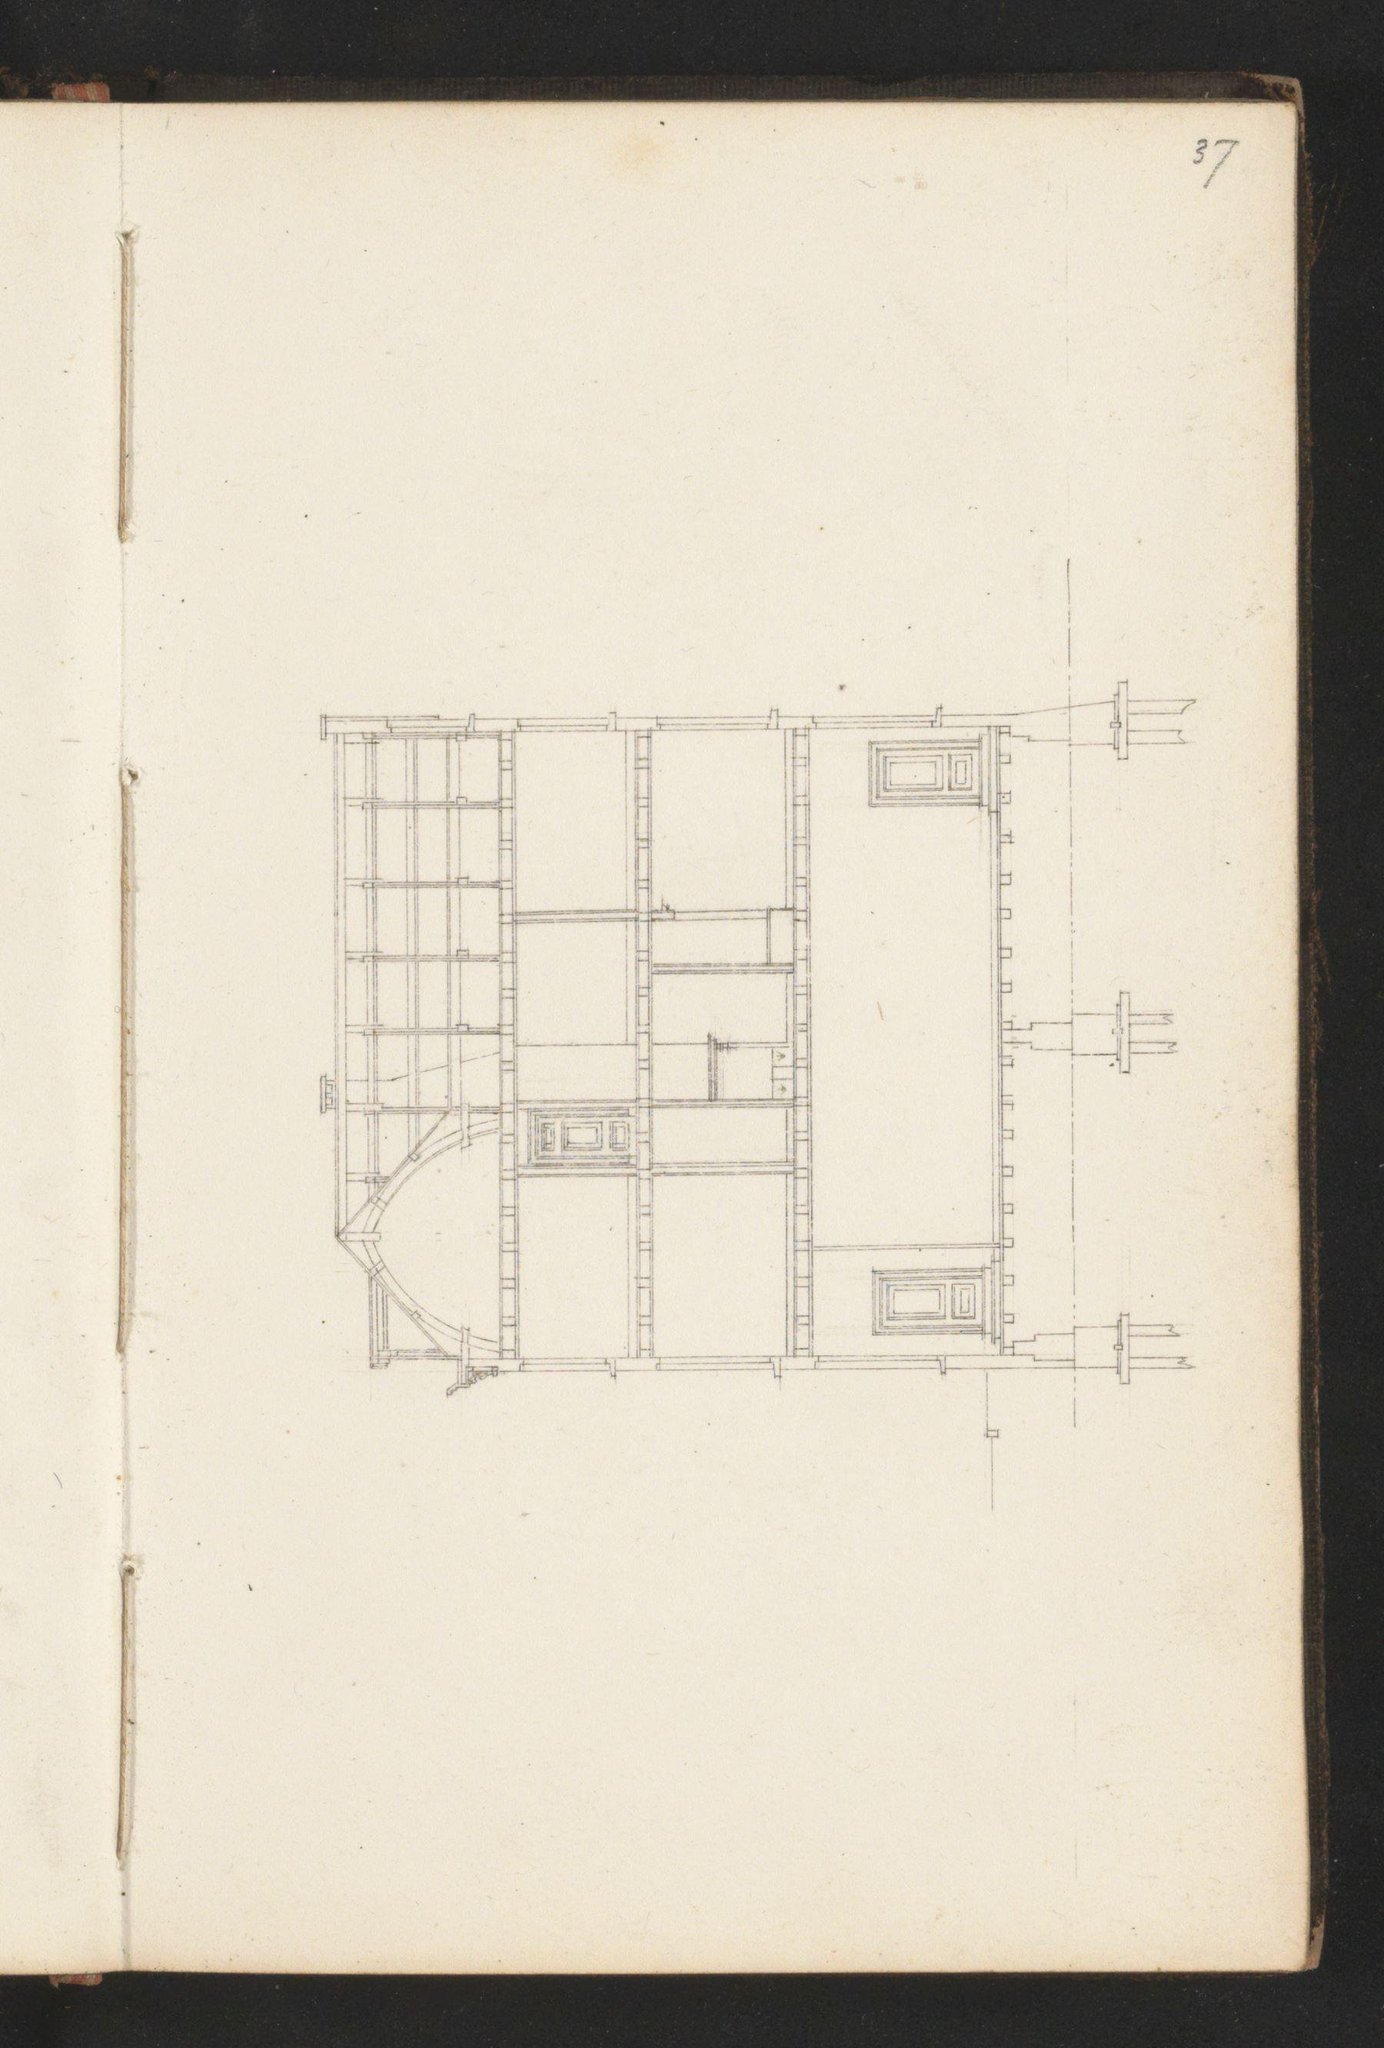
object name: sketchbook leaf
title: Doorsnede van een gebouw over de lengte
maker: willem springer jr.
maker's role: draughtsman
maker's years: 1815-1907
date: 1864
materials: ink, paper, pencil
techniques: pen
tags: section ~ architectural design or model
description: Pagina 37 uit een schetsboek met 164 pagina's.